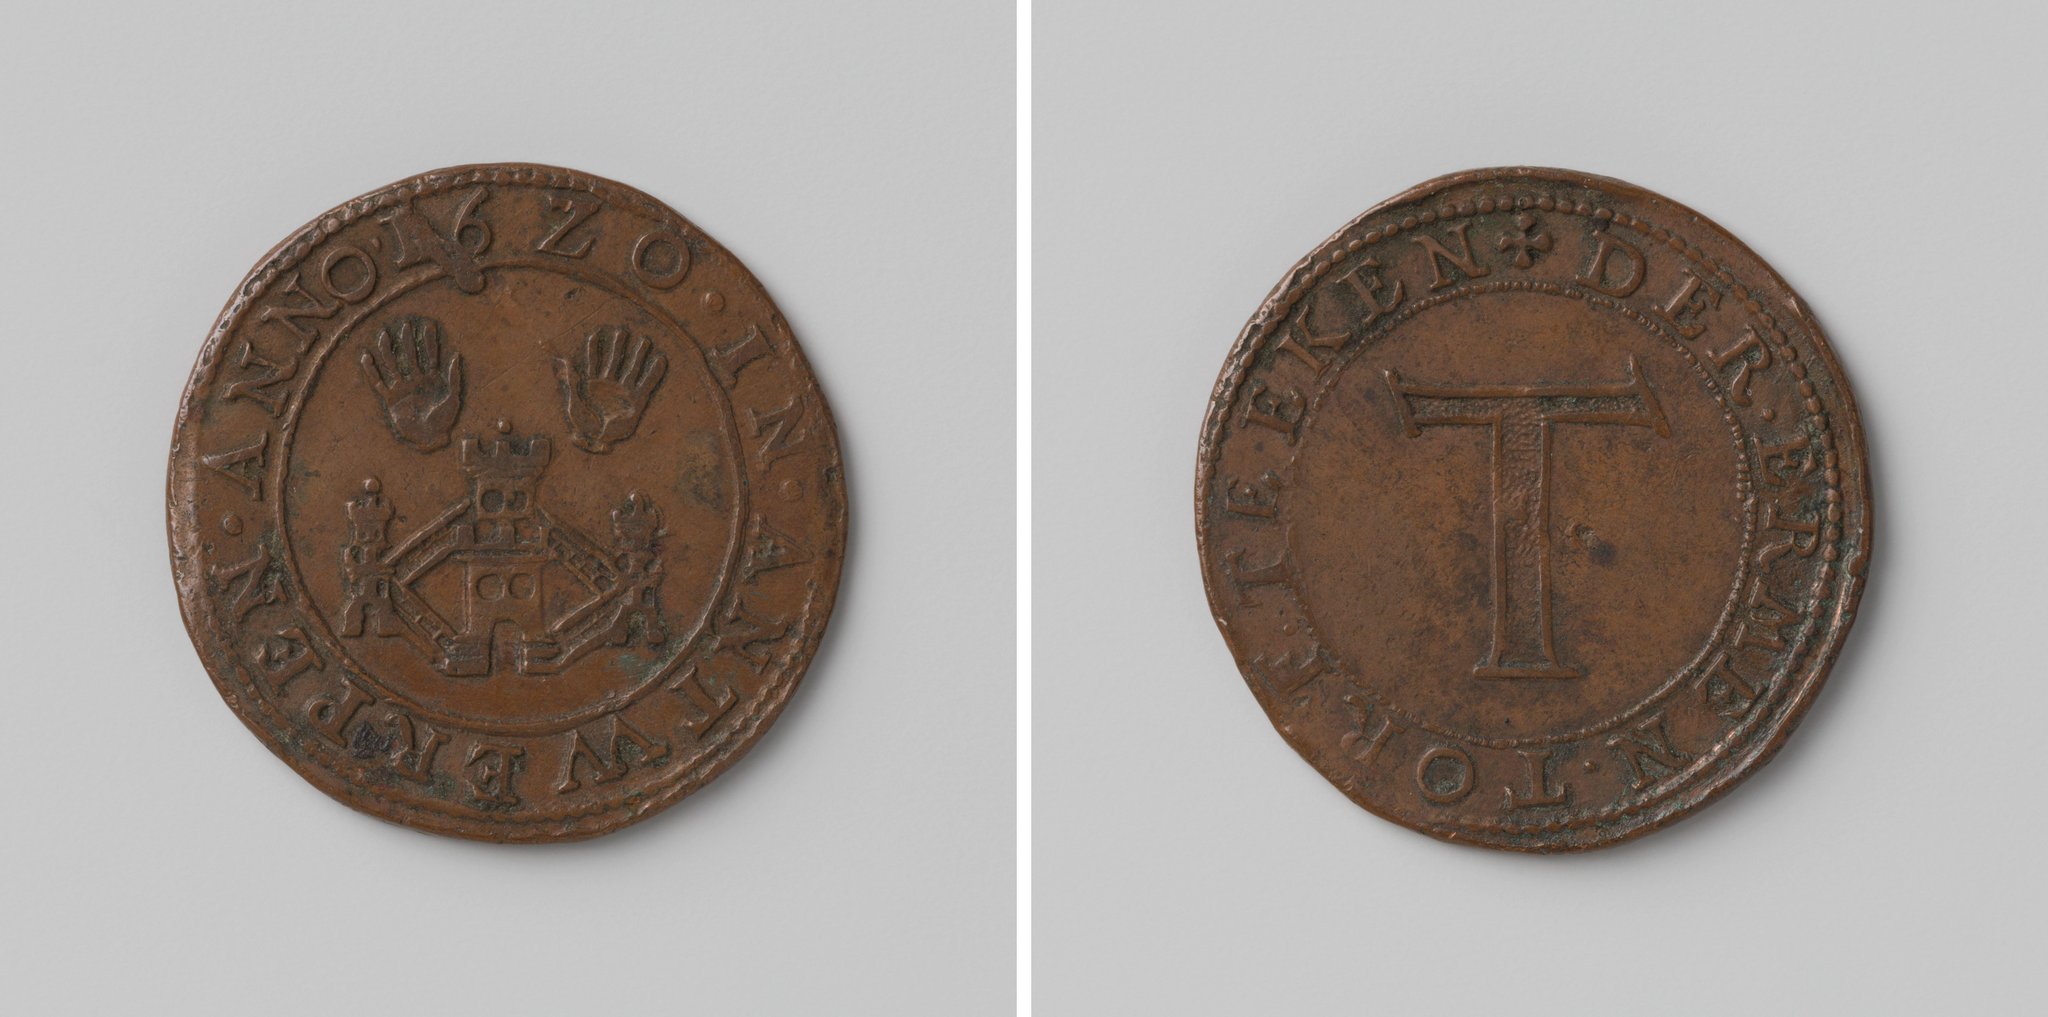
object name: armenloodje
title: Stad Antwerpen, loodje dat bij uitdeling recht gaf op turf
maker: Anonymous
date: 1620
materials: copper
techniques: striking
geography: antwerp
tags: antwerp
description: Koperen penning. Voorzijde: twee geopende handen boven burcht binnen omschrift. Keerzijde: letter T binnen omschrift